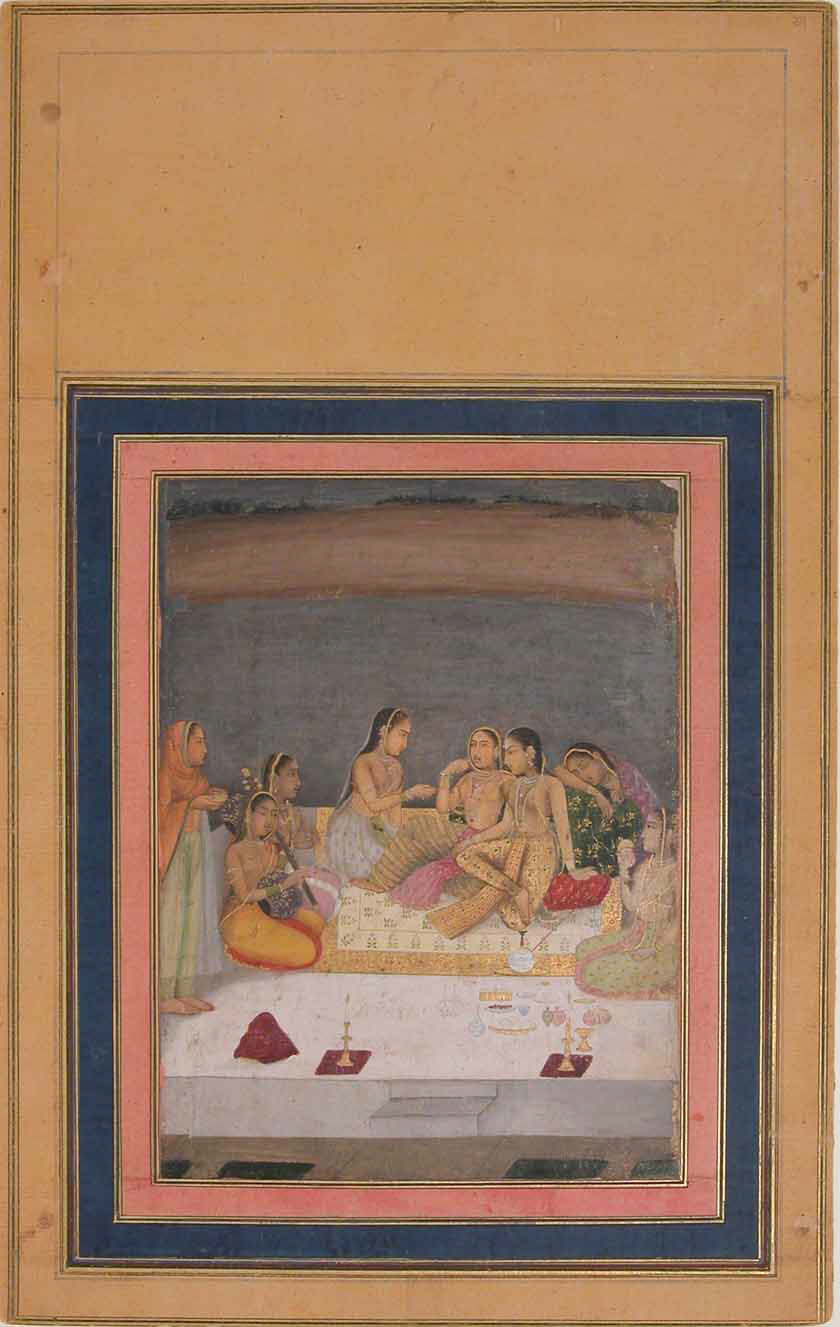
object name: illustrated album leaf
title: "Women on a Balcony", Folio from the Davis Album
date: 1701-1800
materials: gold, ink, paper, watercolor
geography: india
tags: women